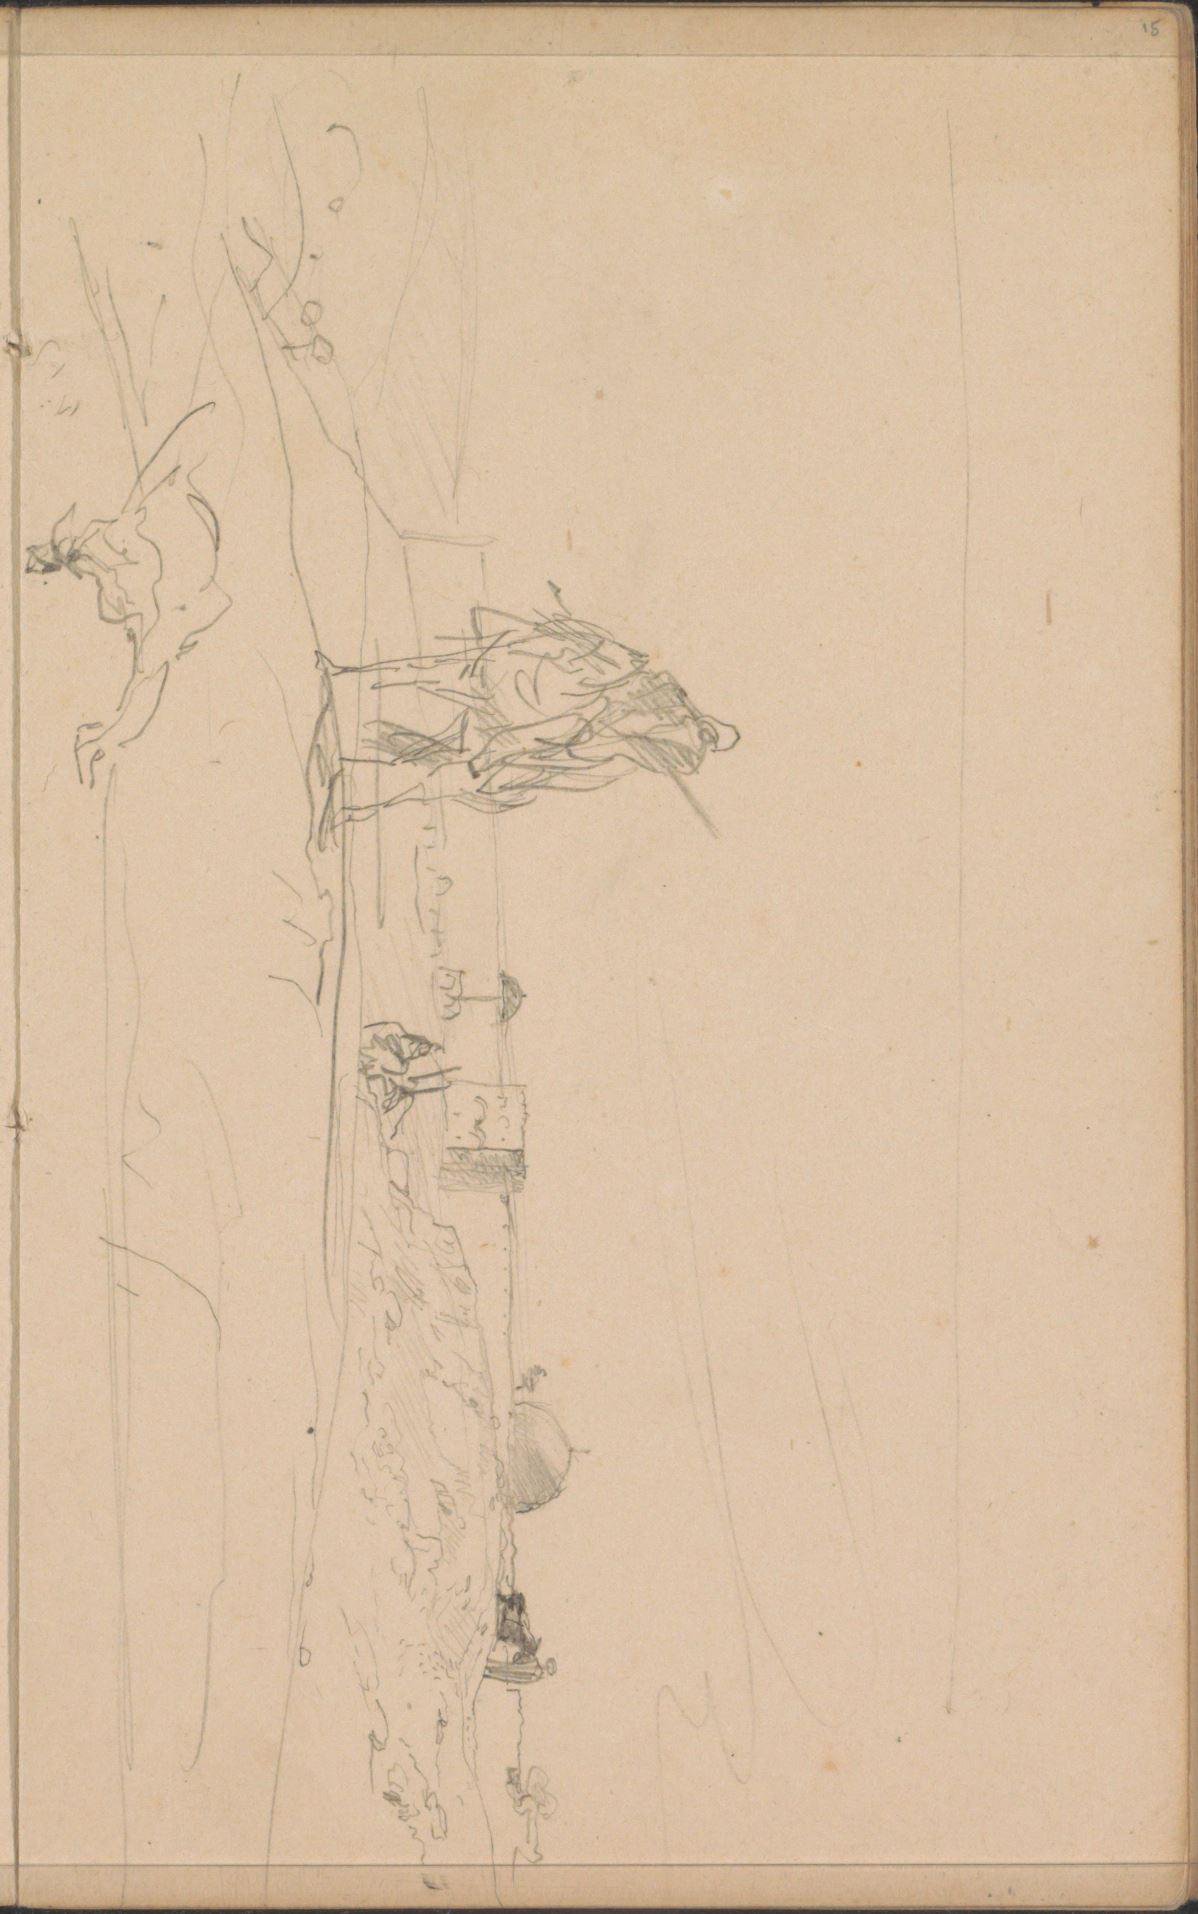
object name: sketchbook leaf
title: Landschap met uitzicht op de Rotskoepel op de Tempelberg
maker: marius bauer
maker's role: draughtsman, print maker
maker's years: 1867-1932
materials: paper, pencil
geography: jerusalem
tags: riding a horse, ass, or mule; rider, horseman, city-view, and landscape with man-made constructions, temple, shrine ~ islam, mohammedanism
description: Op de voorgrond een ruiter. Pagina 15 uit een schetsboek met 36 bladen.